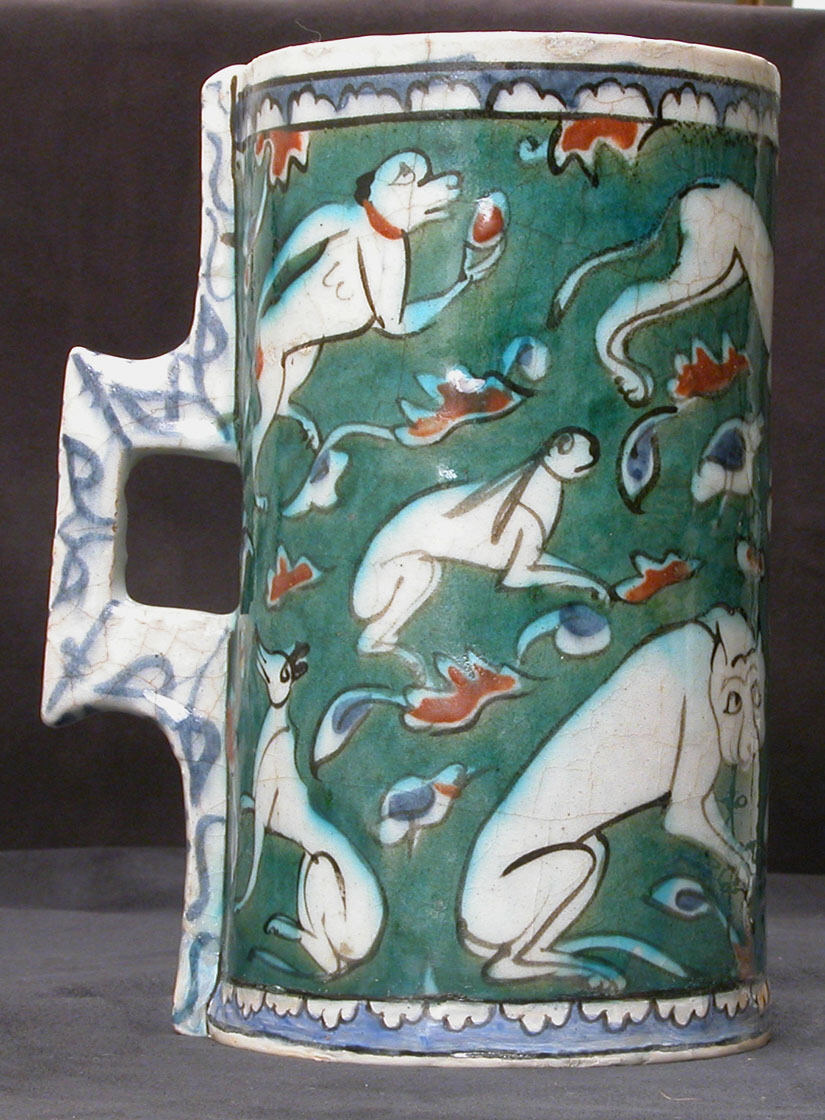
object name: tankard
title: Tankard in Imitation of Metalwork Form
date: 1576-1600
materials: glaze, stonepaste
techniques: painting, polychrome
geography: turkey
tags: animals,rabbits